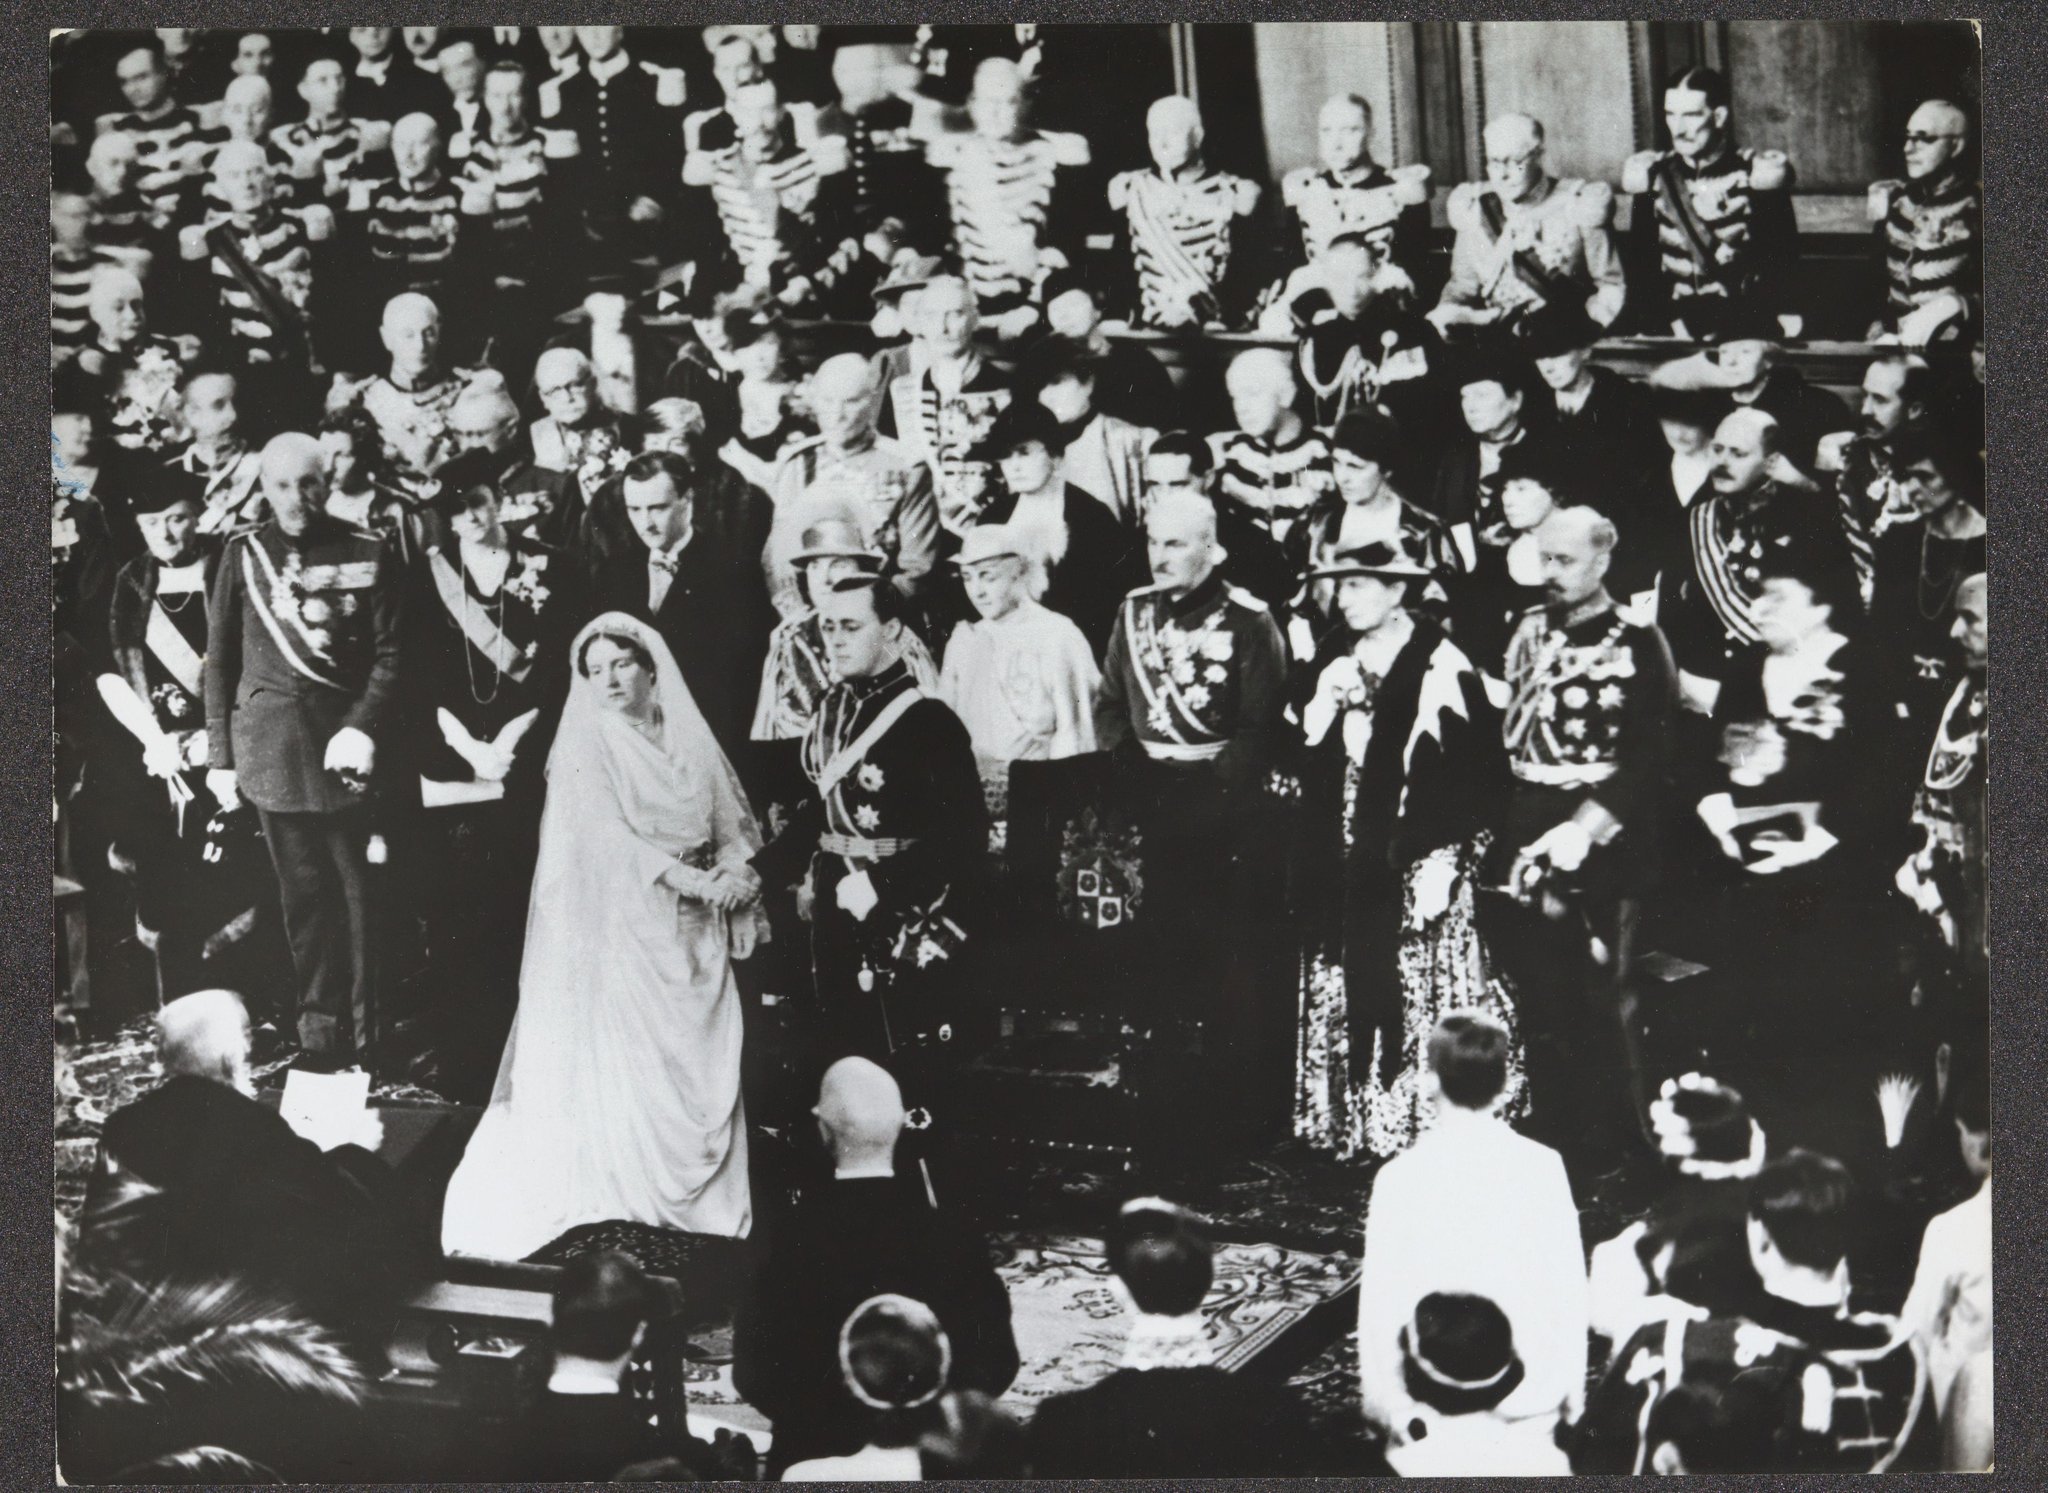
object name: photograph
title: Huwelijksvoltrekking tussen koning Juliana en prins Bernhard in Den Haag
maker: Anonymous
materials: photographic support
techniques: gelatin silver print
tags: utrecht, bernhard (prins der nederlanden), juliana of the netherlands, the hague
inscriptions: stamp: ‘copyright Anefo, Kerkstraat 310 Amsterdam PRF 72’, inscription: ‘Huwelijk Pr. Juliana en Pr. Bernhard. Inzegen. in Sint Jacobskerk Haag 7/1 '37’